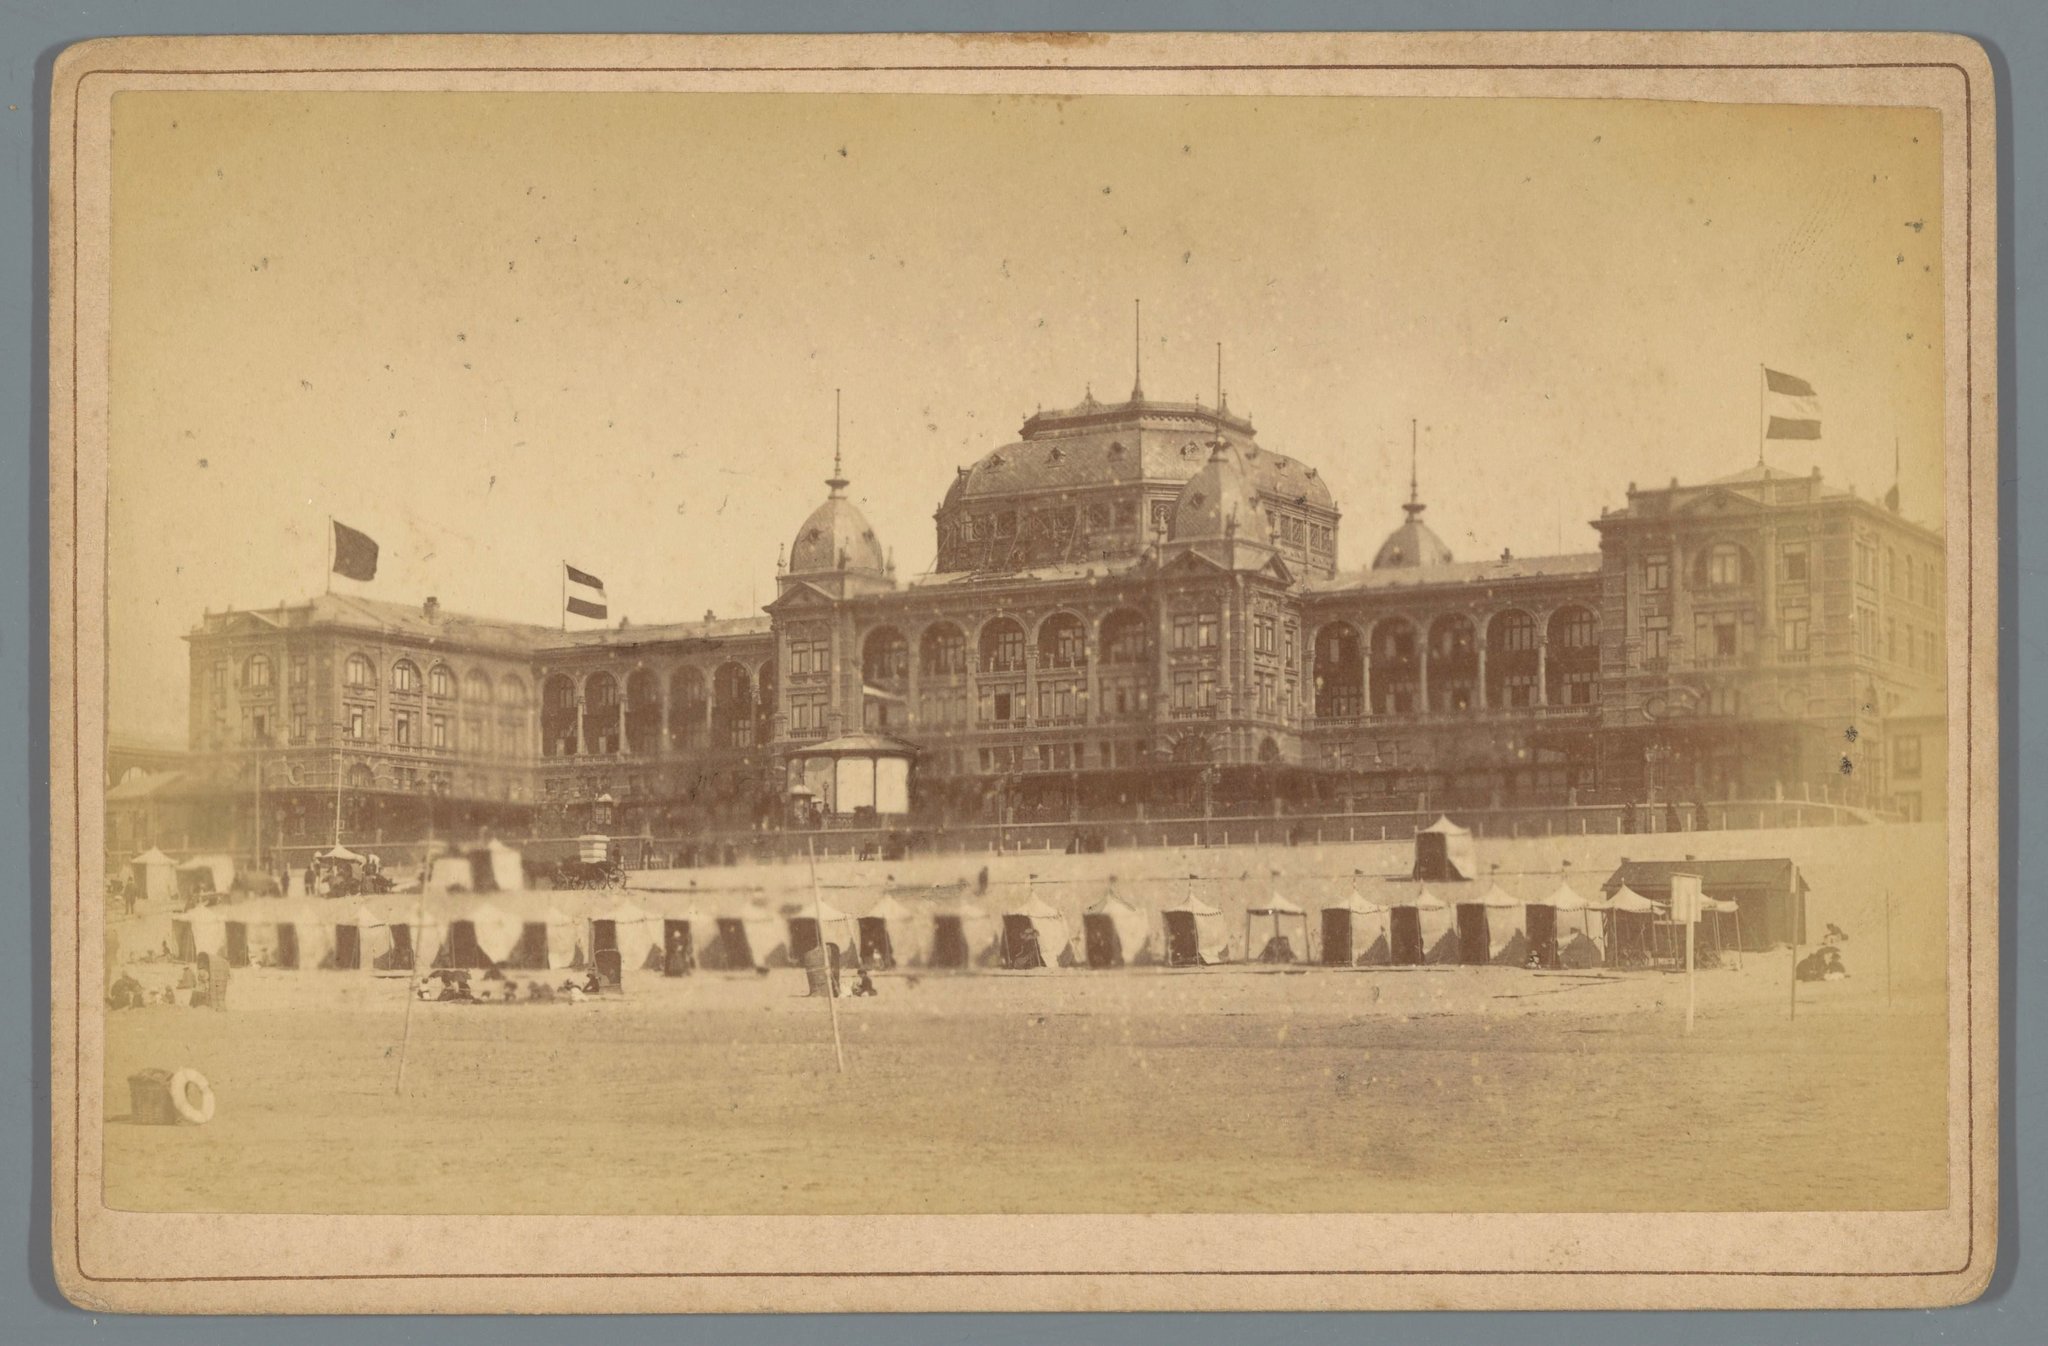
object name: cabinet photograph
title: Exterieur van het eerste Kurhaus te Scheveningen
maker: willem frederik vinkenbos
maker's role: fotograaf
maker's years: 1831-1896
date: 1885-1886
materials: cardboard, photographic support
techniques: albumen print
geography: scheveningen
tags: façade (of house or building), hotel, hostelry, inn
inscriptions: name: ‘Photographie W.F. Vinkenbos De Riemerstraat 111 Den Haag’